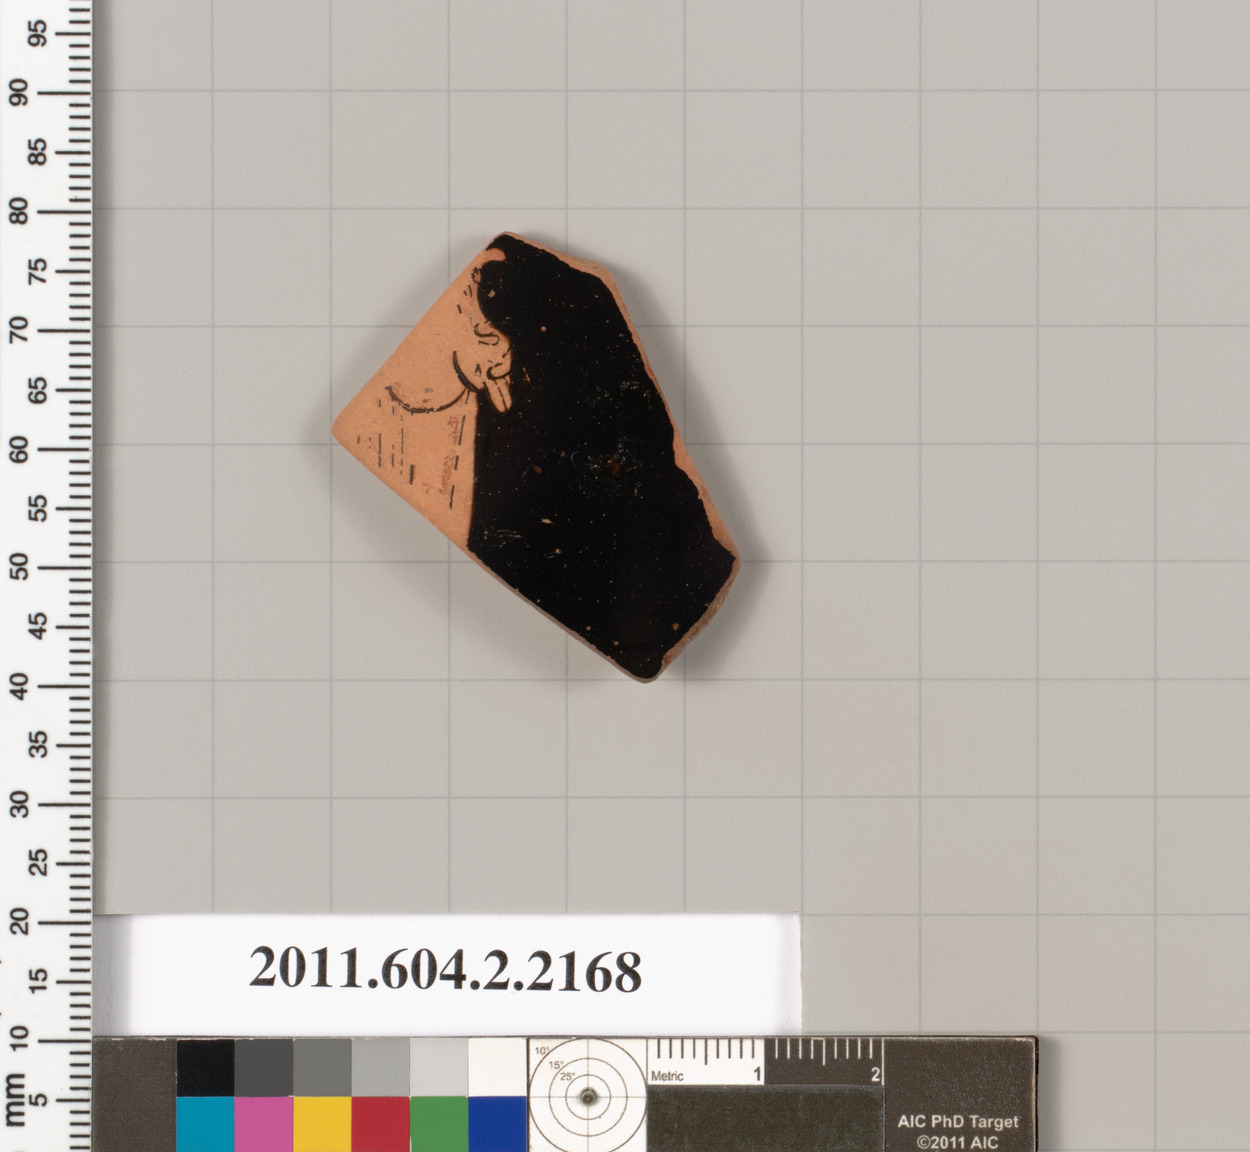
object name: pot fragment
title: Terracotta fragment of a pot; unglazed on the inside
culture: greek, attic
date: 475-451 BCE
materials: terracotta